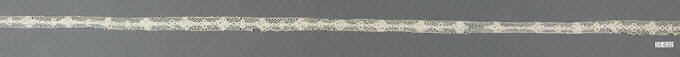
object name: insertion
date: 1800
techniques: lace